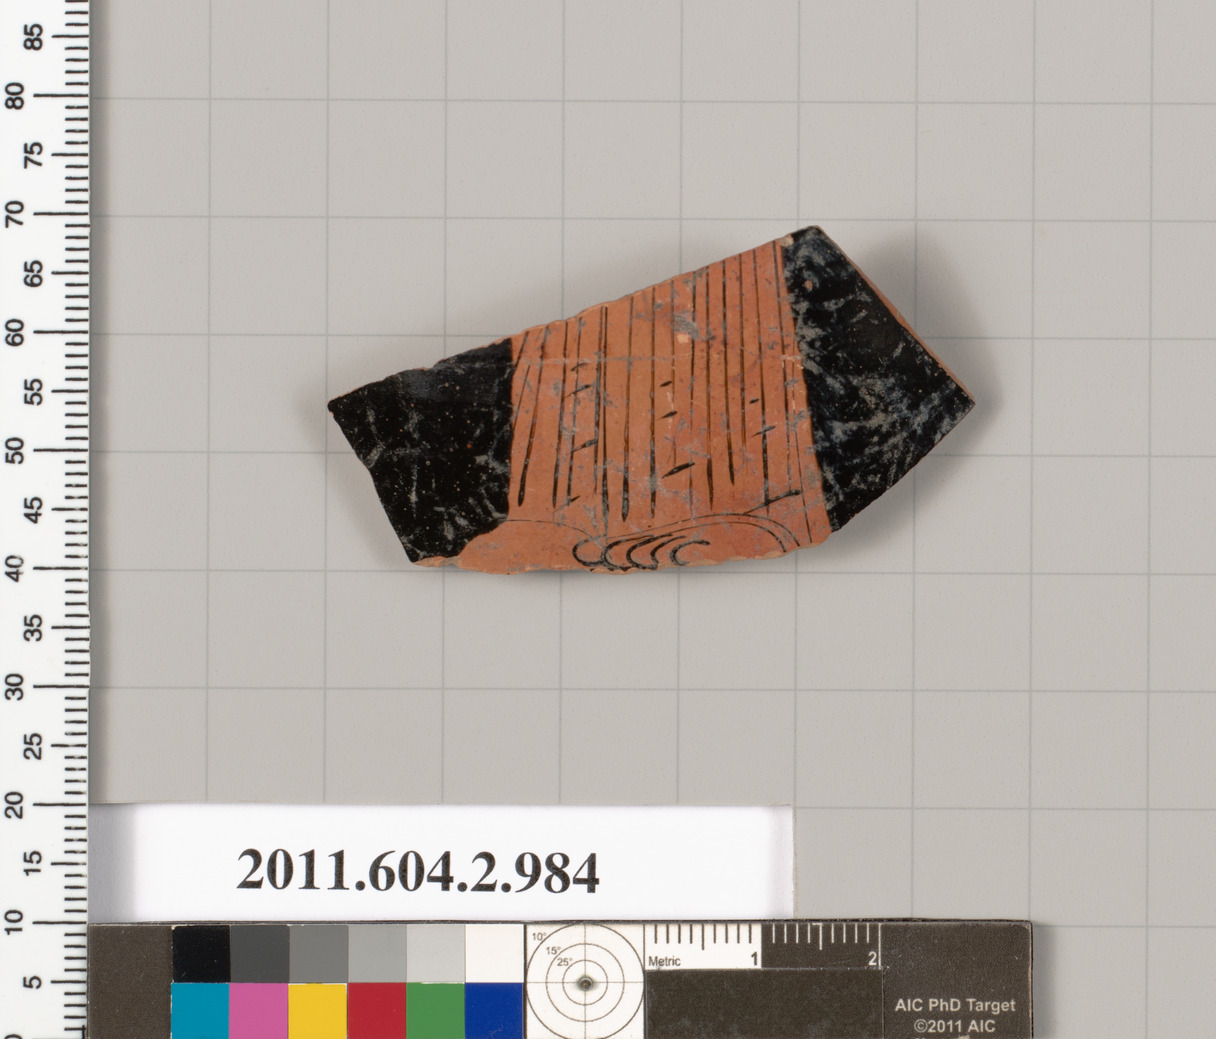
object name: oinochoe fragment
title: Terracotta fragment of an oinochoe (jug)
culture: greek, attic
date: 460-440 BCE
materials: terracotta